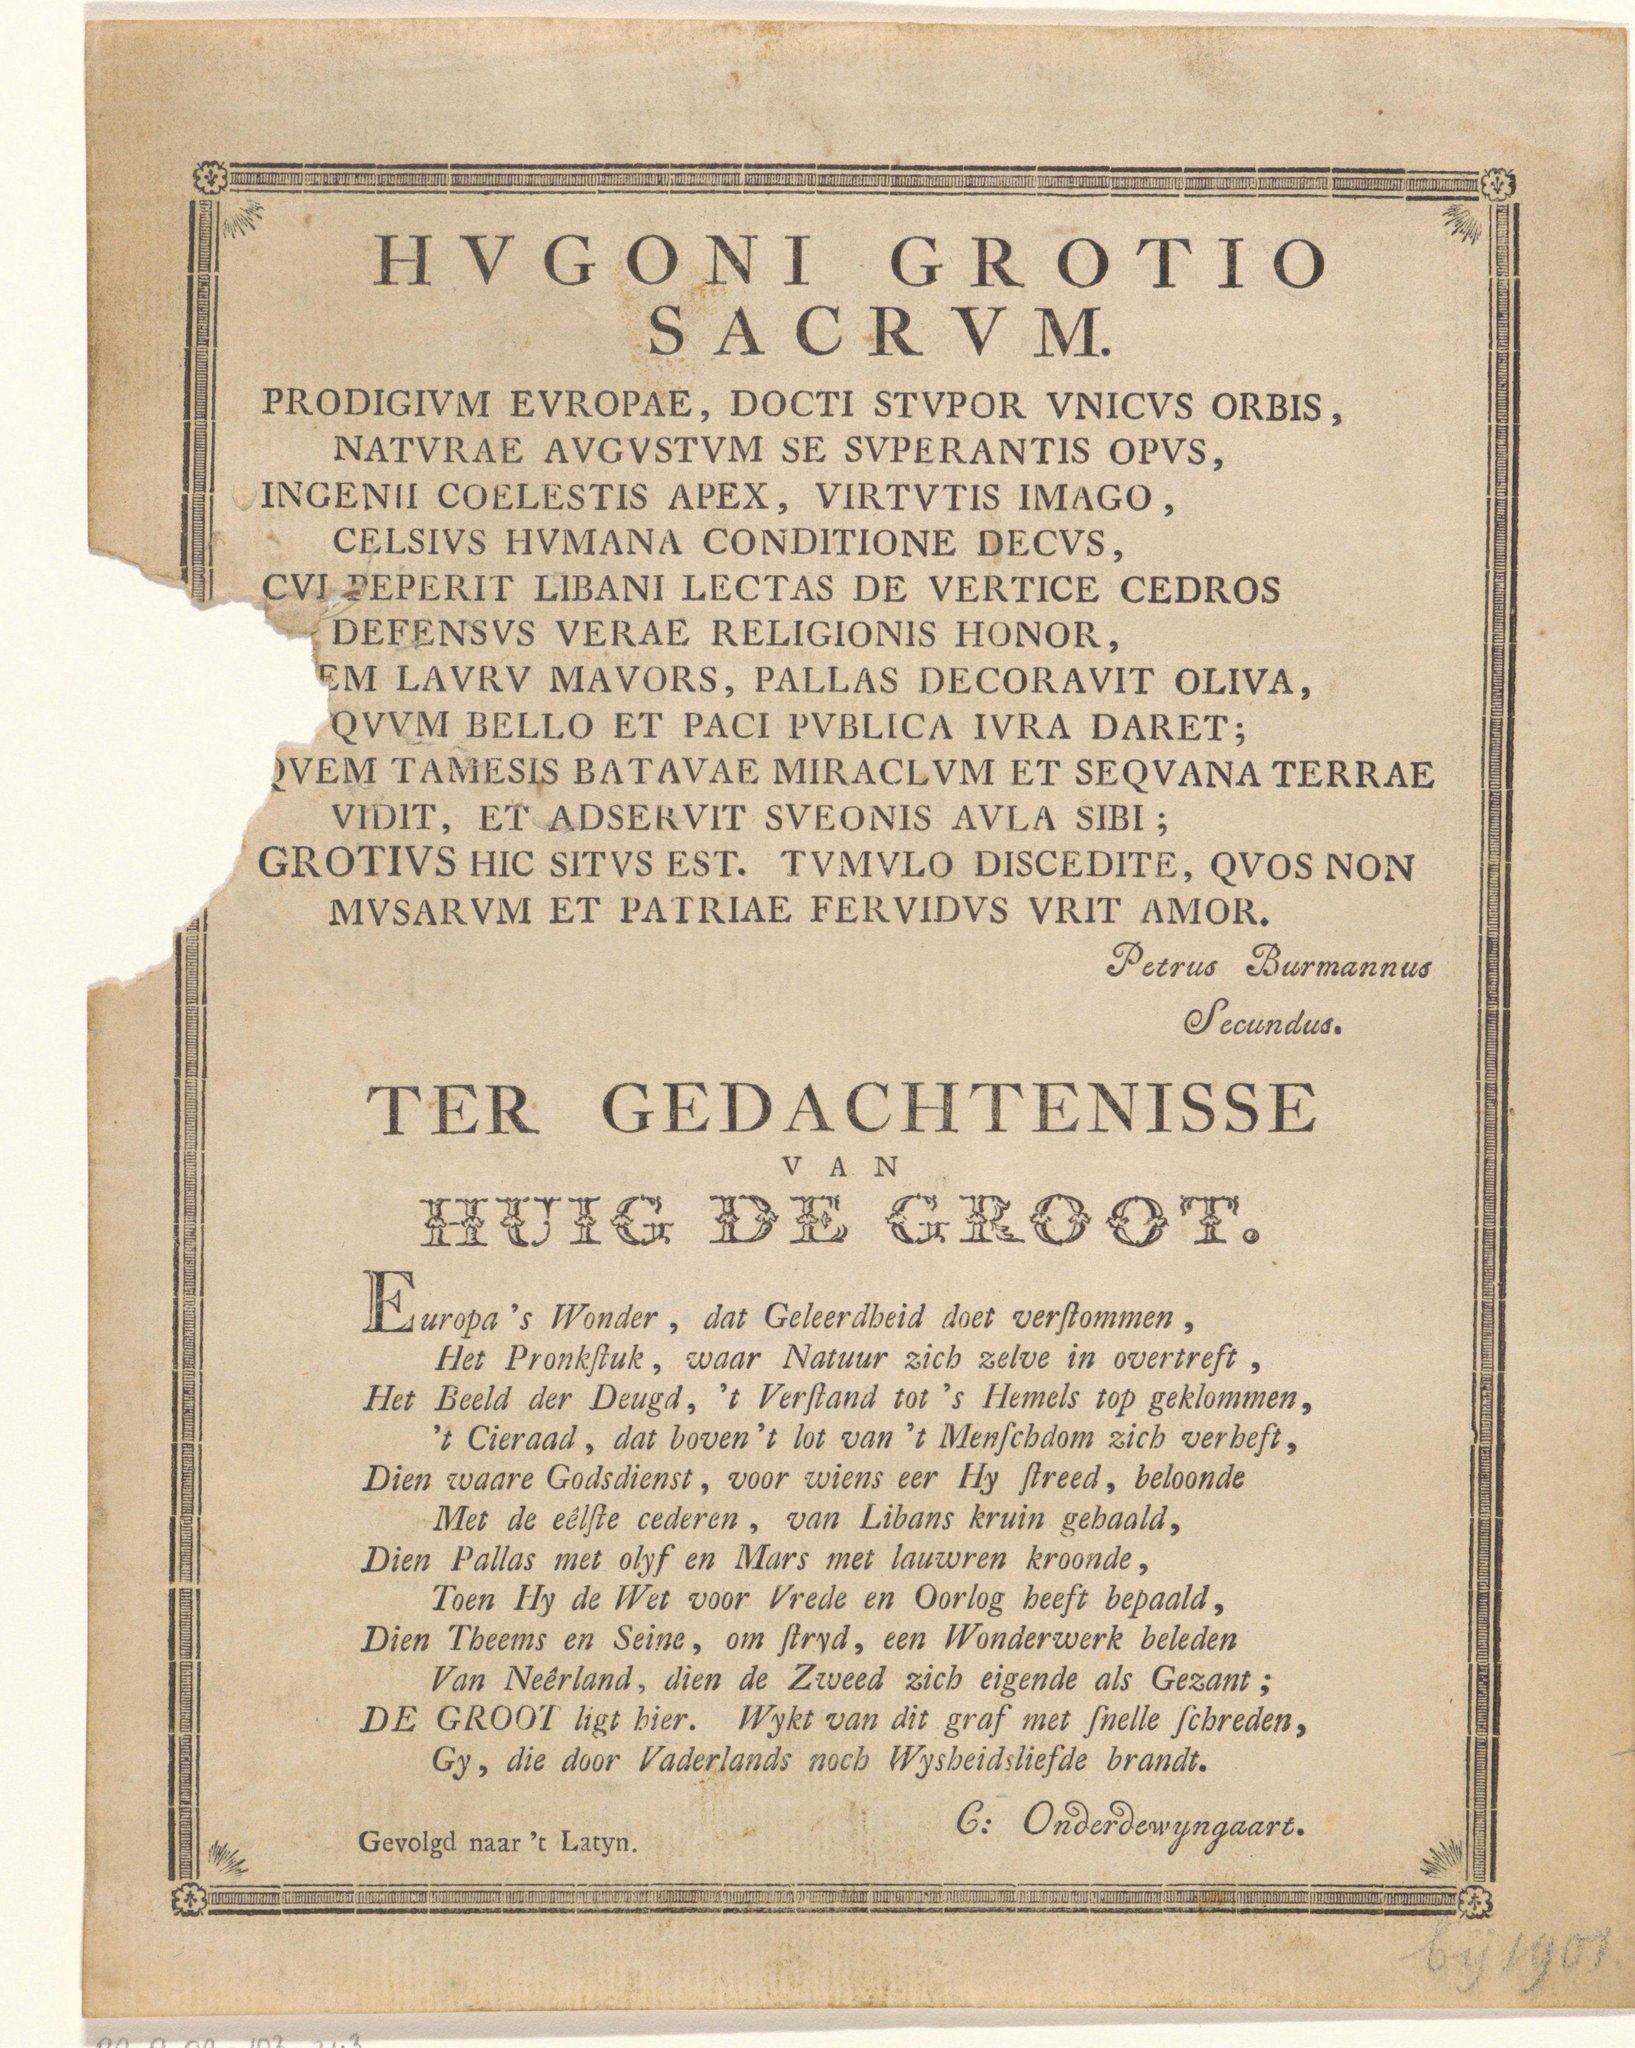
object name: text sheet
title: Opschrift op het monument voor Hugo de Groot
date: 1781-1800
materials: paper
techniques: letterpress printing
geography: delft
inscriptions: collector's mark: Lugt 2228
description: De Latijnse tekst, zoals die is vermeldt op het in 1781 opgerichtte monument voor Hugo de Groot in de Nieuwe Kerk te Delft. Daaronder de vertaling van dezelfde tekst in het Nederlands.